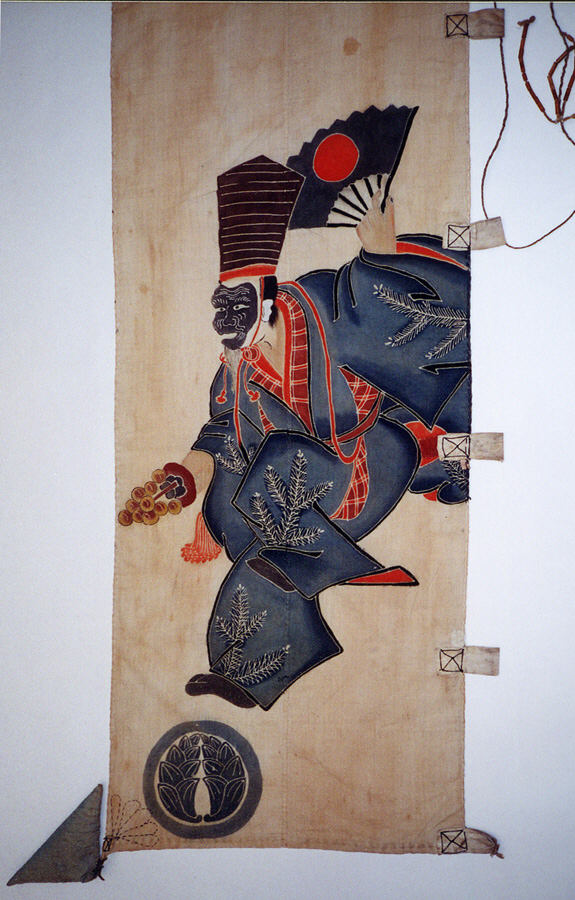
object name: banner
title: Banner (Nobori)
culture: japanese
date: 1827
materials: bamboo, cotton, hemp, paper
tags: masks,fans,men